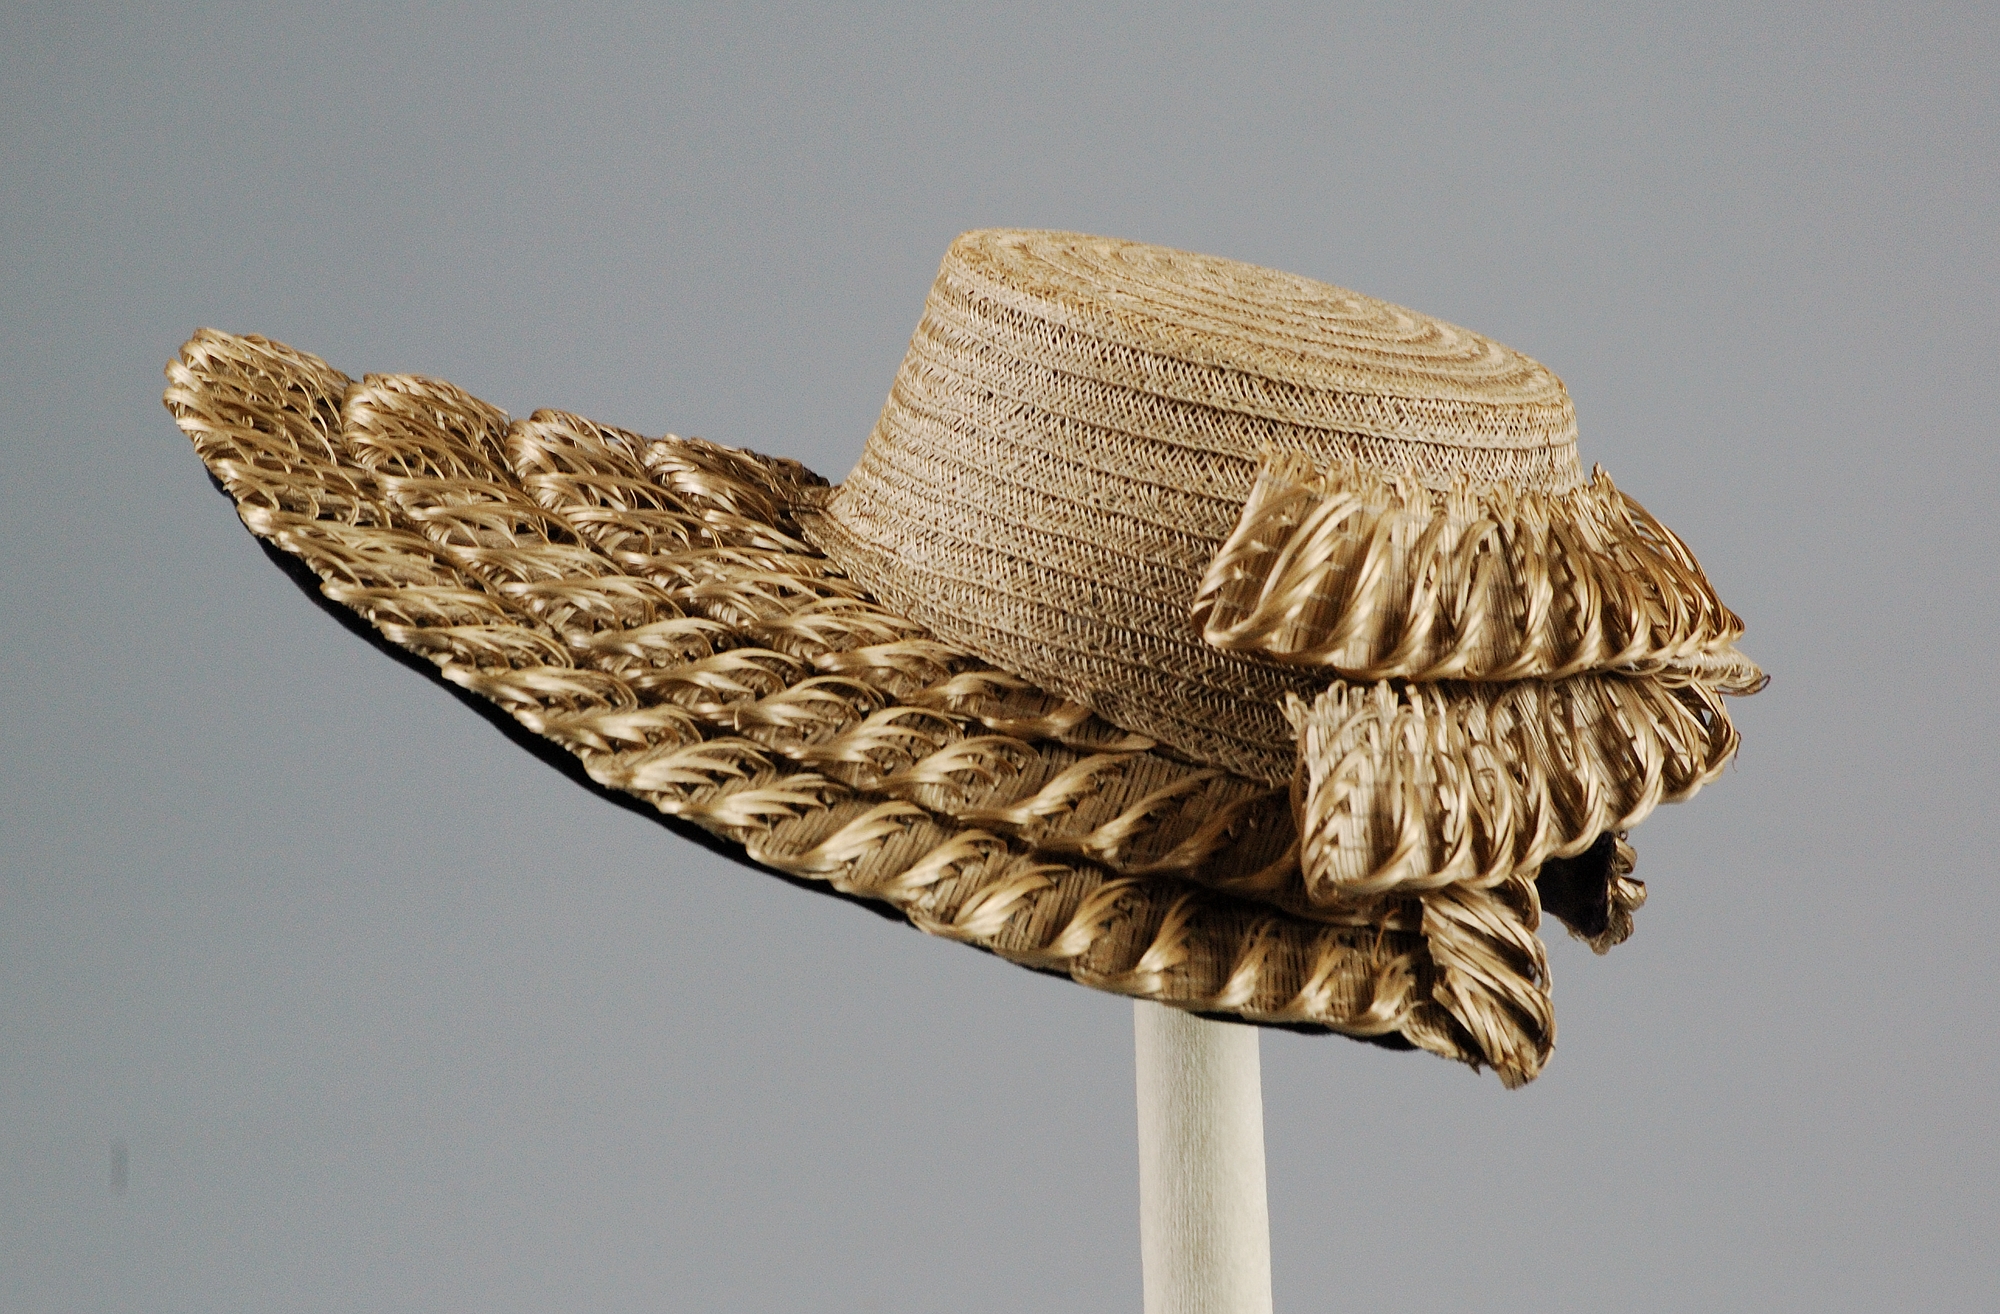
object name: bonnet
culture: american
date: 1875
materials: silk, fiber